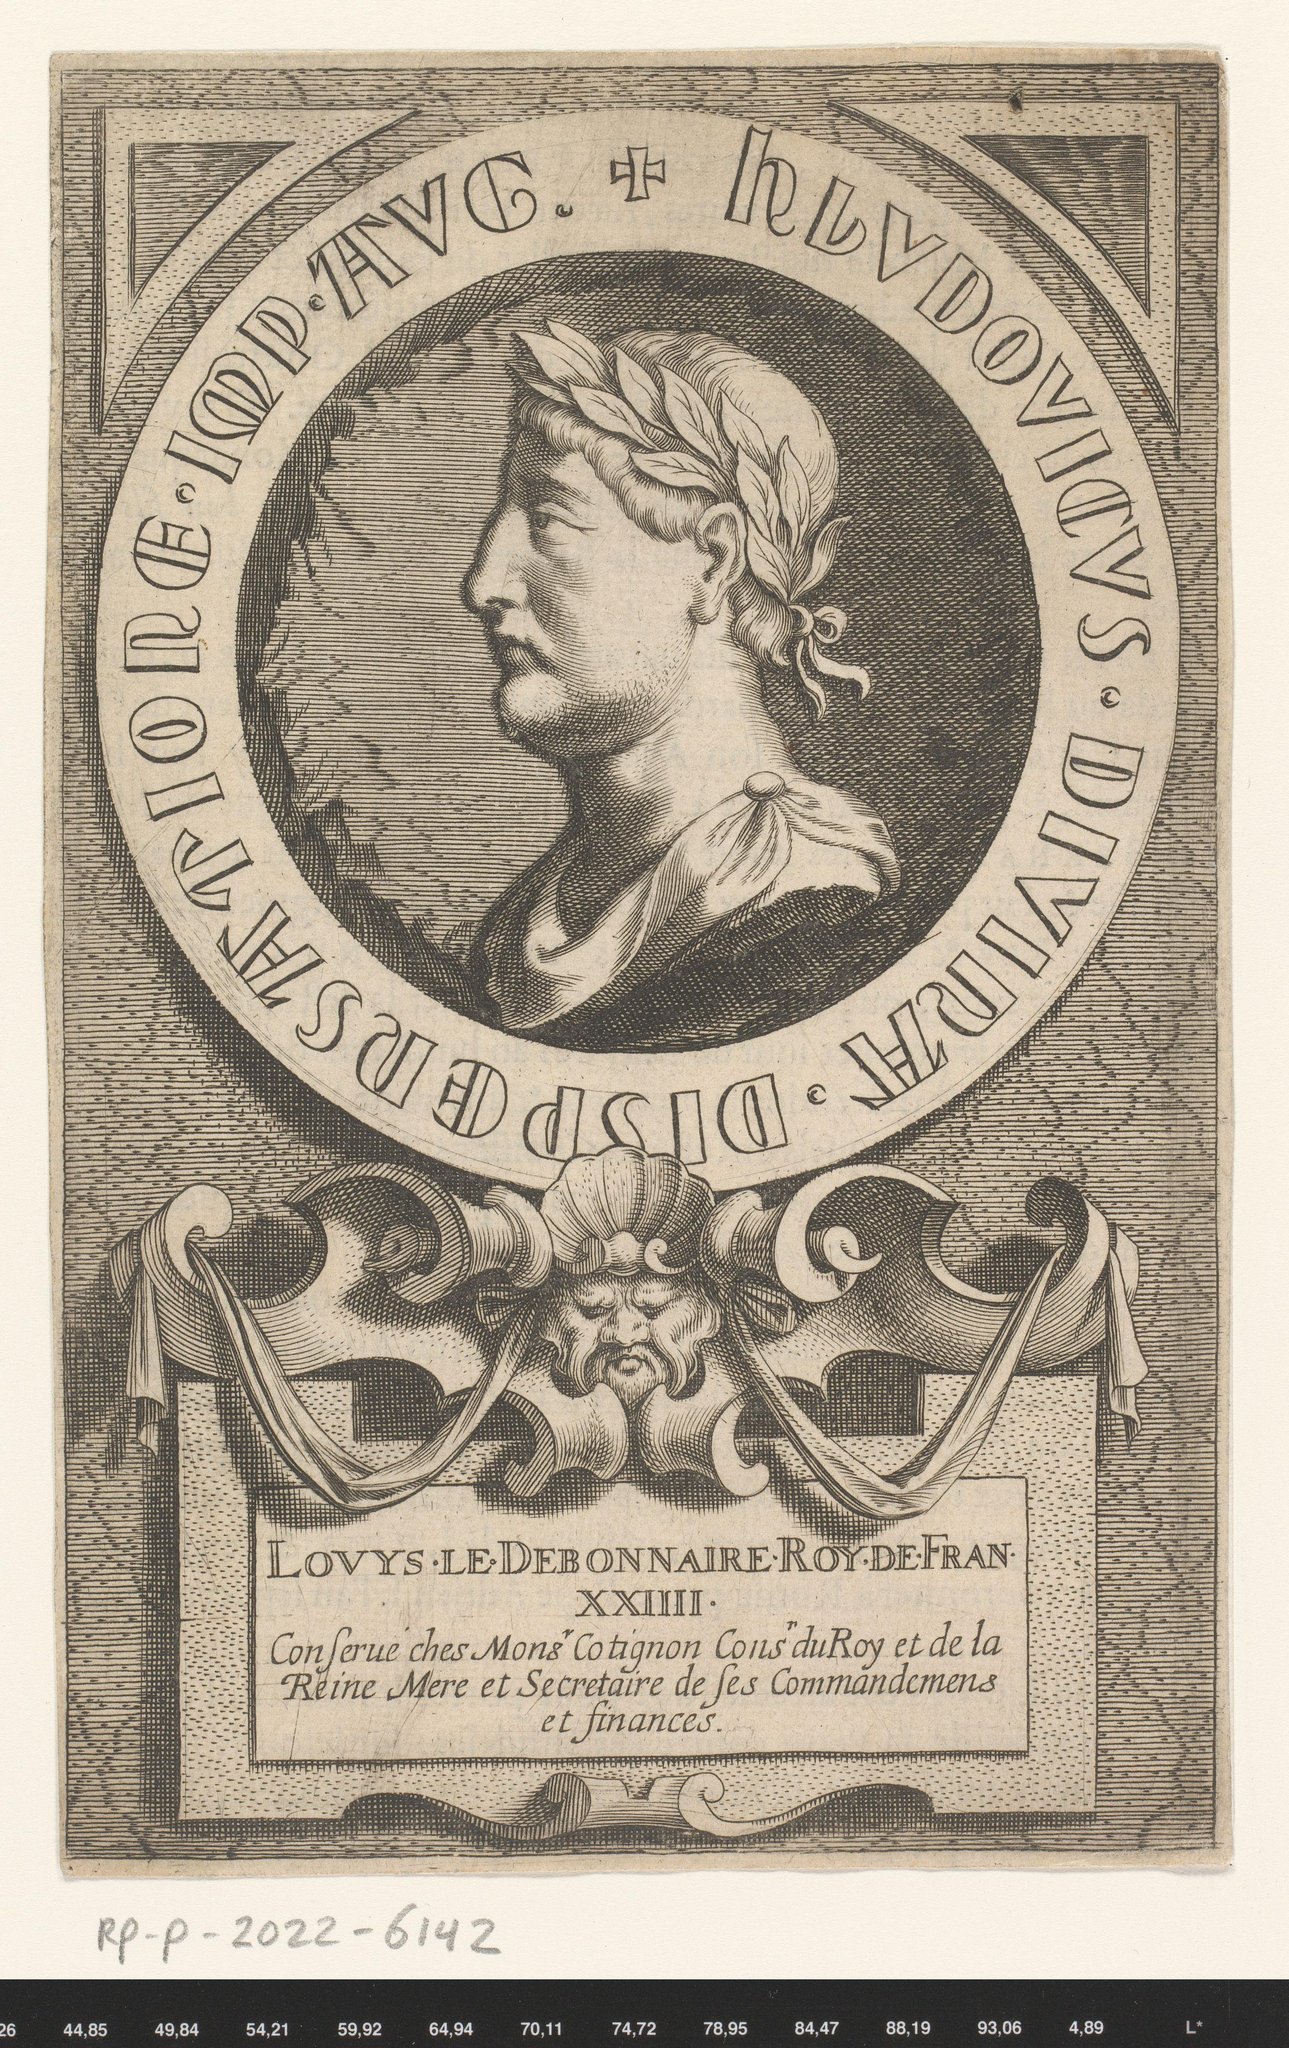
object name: book illustration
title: Portret van Lodewijk de Vrome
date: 1636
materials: paper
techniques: engraving, letterpress printing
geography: paris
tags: france, historical persons, king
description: Prent uit: Bie, Jacob de. Les vrais portraits des rois de France. (...) Parijs: Jean Camusat, 1636, dl. 2, p. 131.